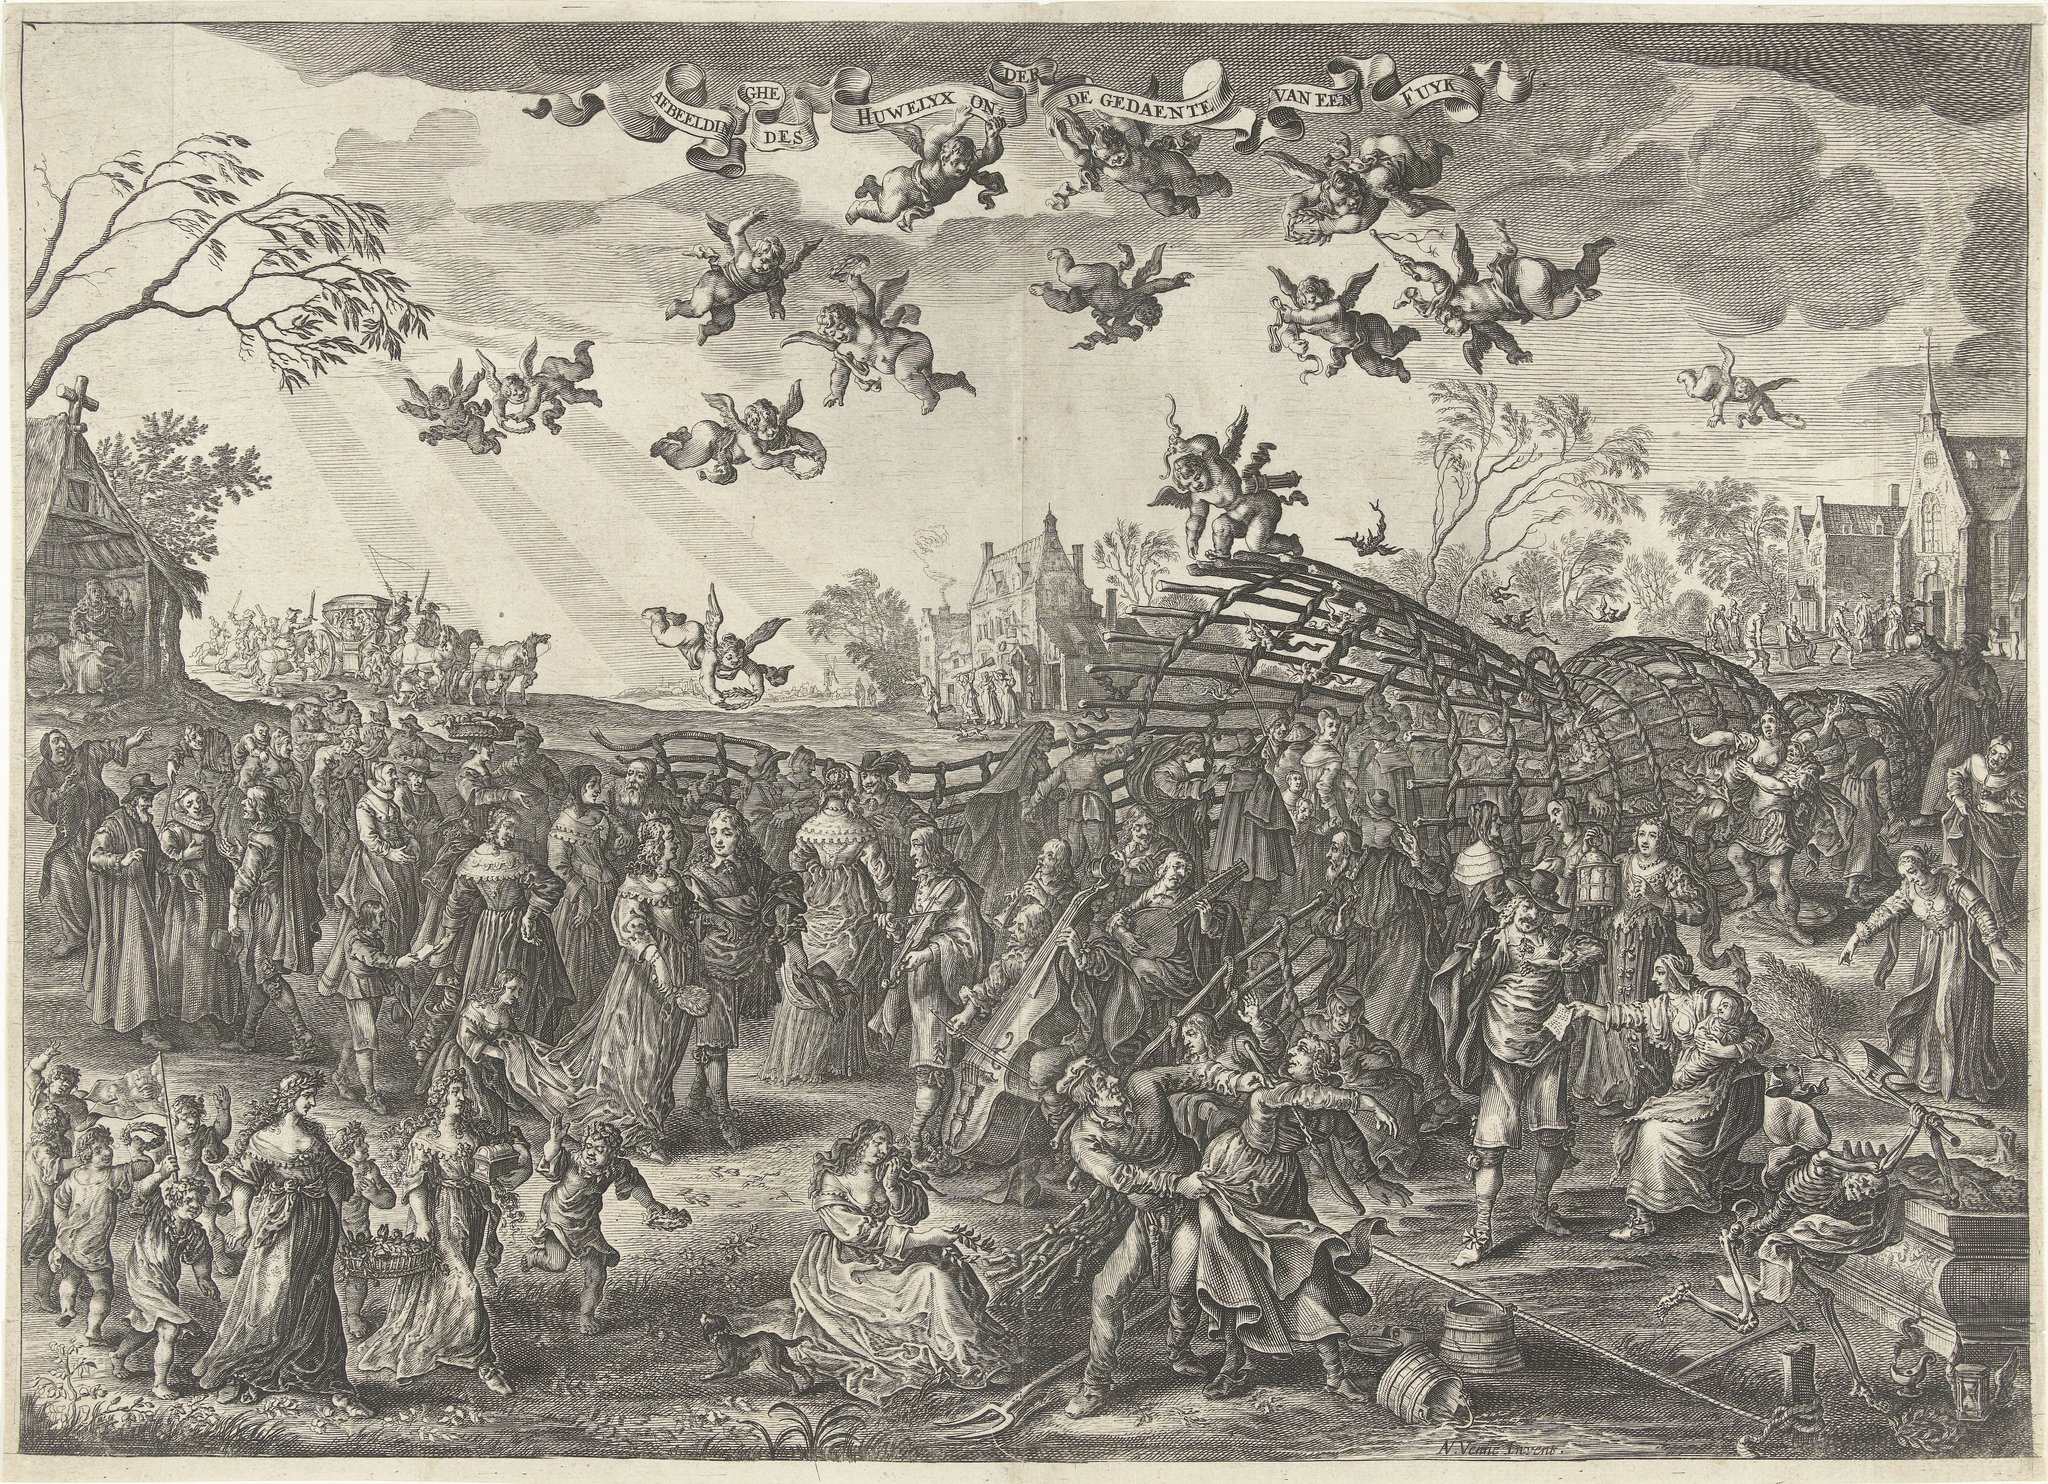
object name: print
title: Afbeeldinghe des huwelyx onder de gedaente van een fuyk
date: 1655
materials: paper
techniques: engraving, etching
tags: marriage, married couple, 'matrimonium'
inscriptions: collector's mark: Lugt 2228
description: De huwelijksfuik, allegorie op het huwelijk. Paren lopen gearmd een grote fuik of vangnet binnen onder begeleiding van muziek van een klein orkest. Bovenop de fuik zit Cupido. Putti dansen rond een bruidspaar met bloemenmand. Om de fuik lopen mannen en vrouwen, zij maken allerlei erotische toespelingen. rechts zwaait de Dood met een hakbijl.